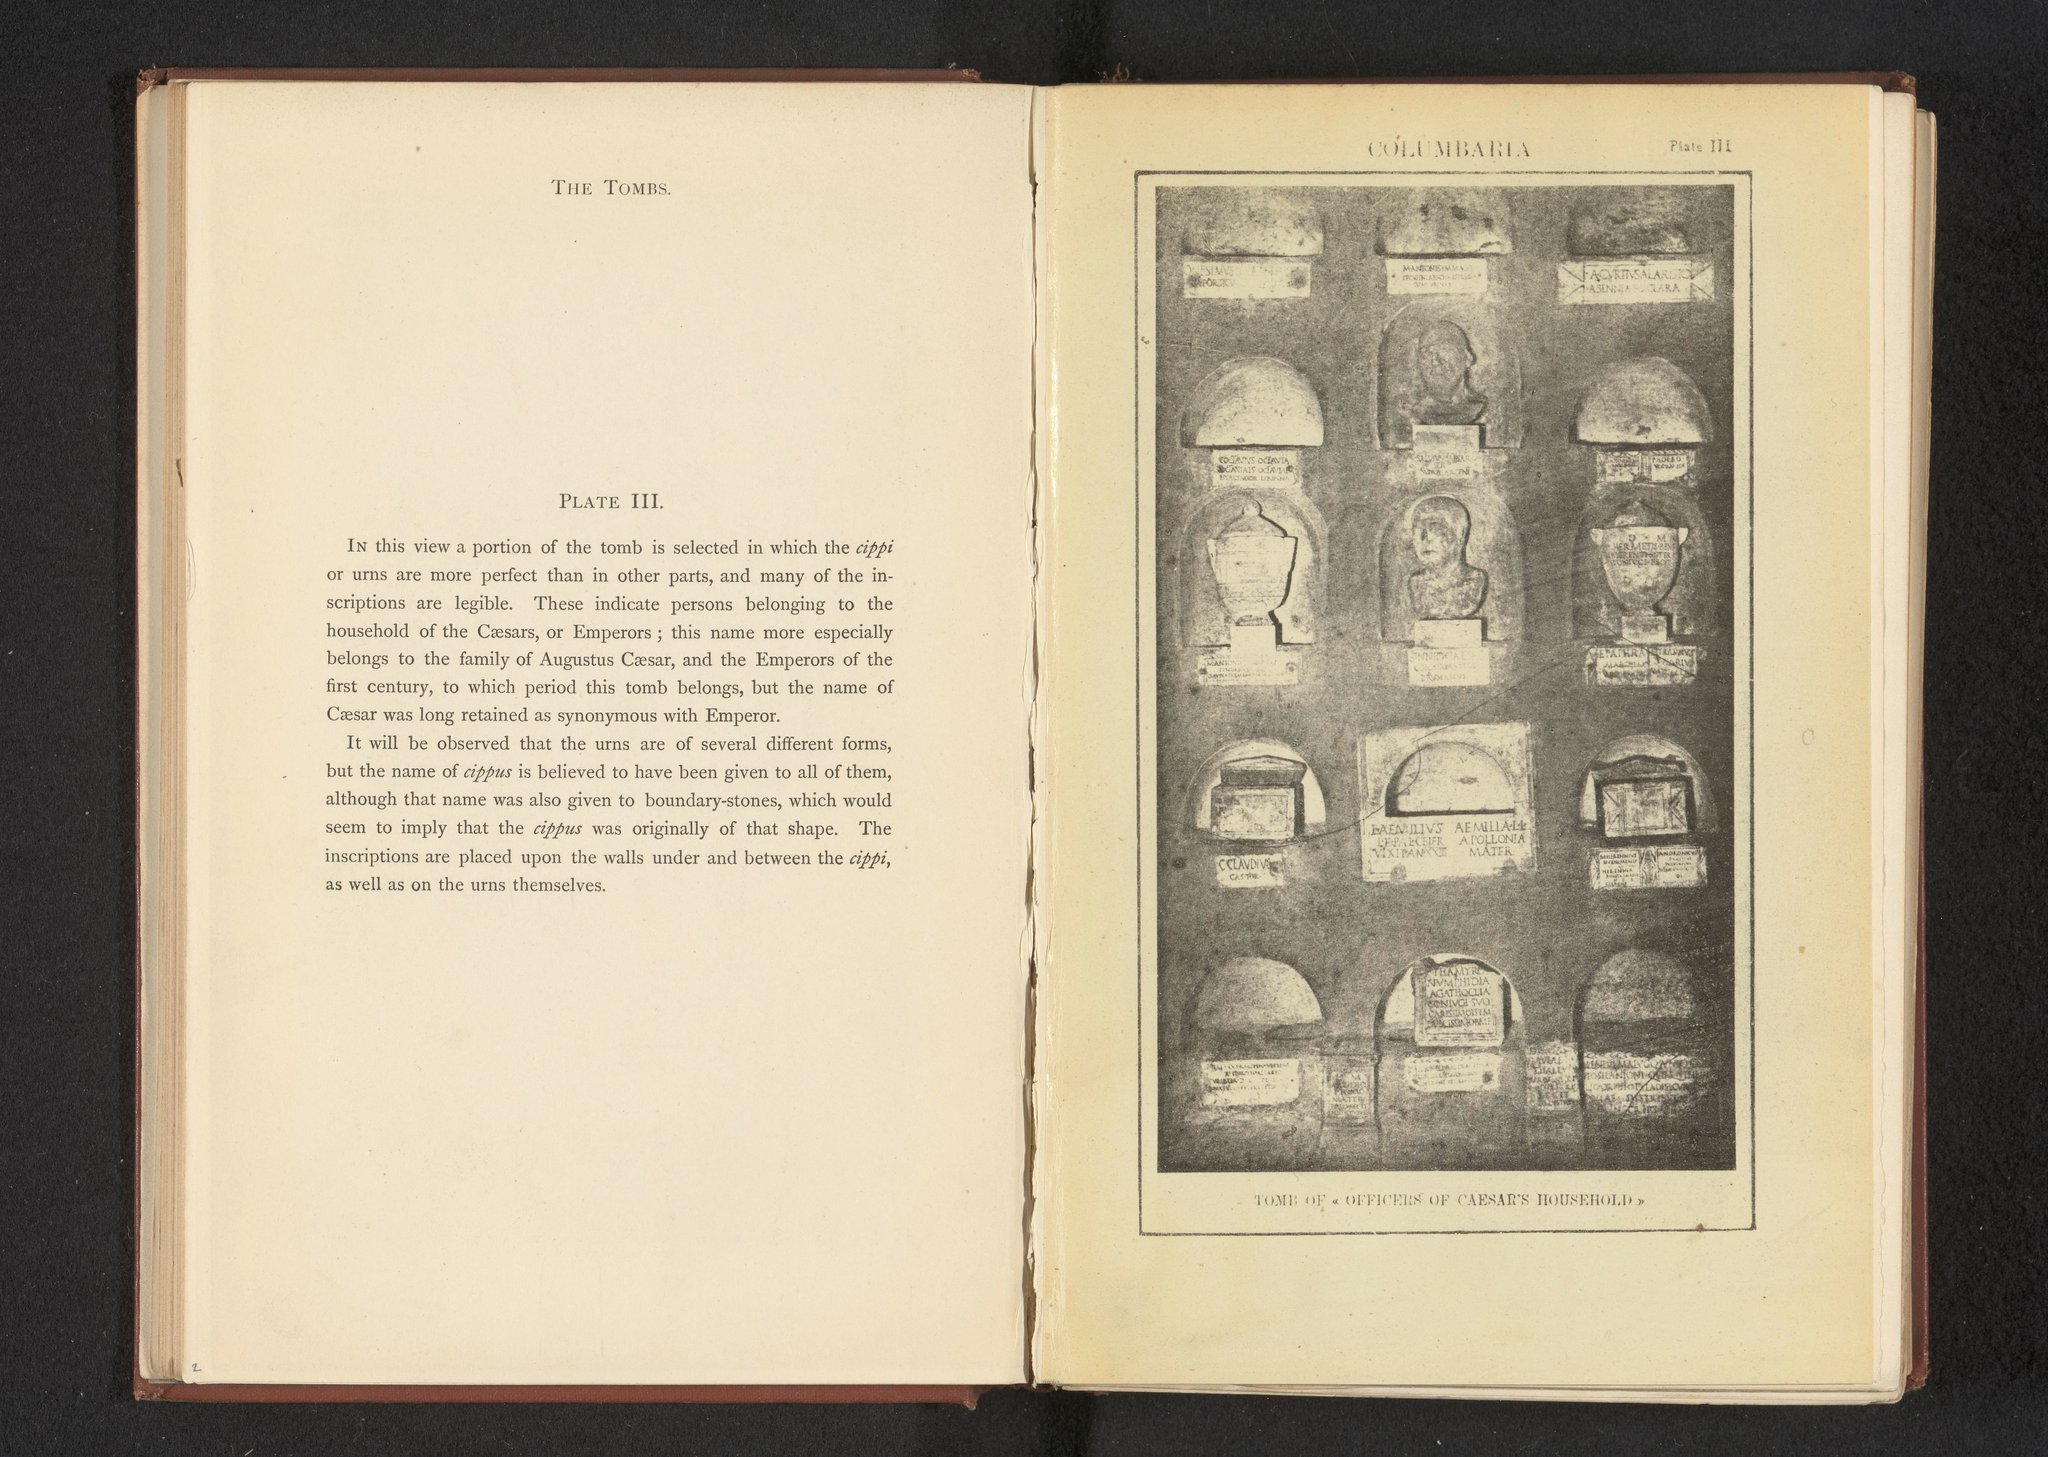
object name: photomechanical print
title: Columbaria Tomb of “The officers of Ceasar's household”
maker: Anonymous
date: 1867-1877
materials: paper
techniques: photoaquatint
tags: niche-tomb, wall-tomb, urn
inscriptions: number: ‘Plate III’